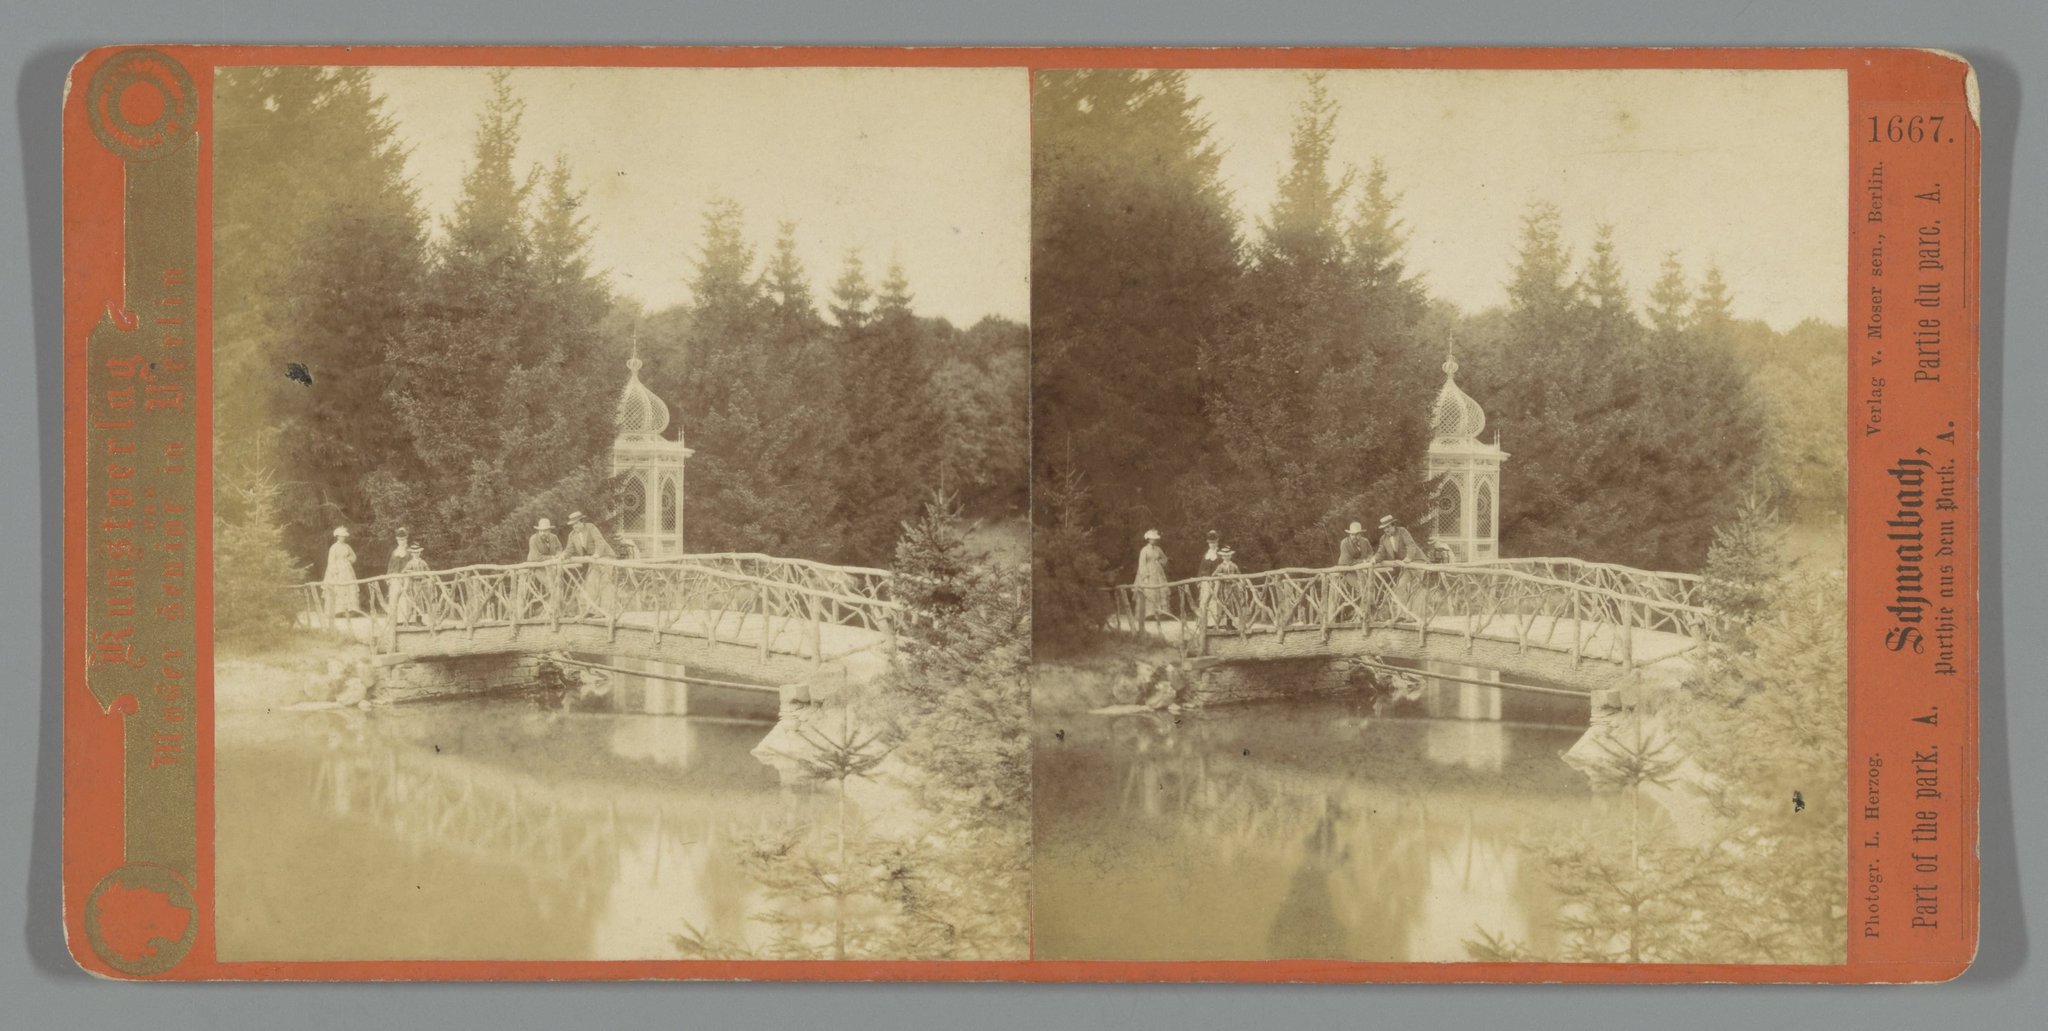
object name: stereograph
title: Schwalbach, Parthie aus dem Park. A.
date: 1860-1880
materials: cardboard, photographic support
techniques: albumen print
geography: bad schwalbach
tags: bridge, public gardens, park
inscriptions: inscription: ‘Photographischer und Stereoscopischer Kunstverlag (...) Glas-u. Papier- Stereoscopbildern aller Weltgegenden’, number: ‘1667.’